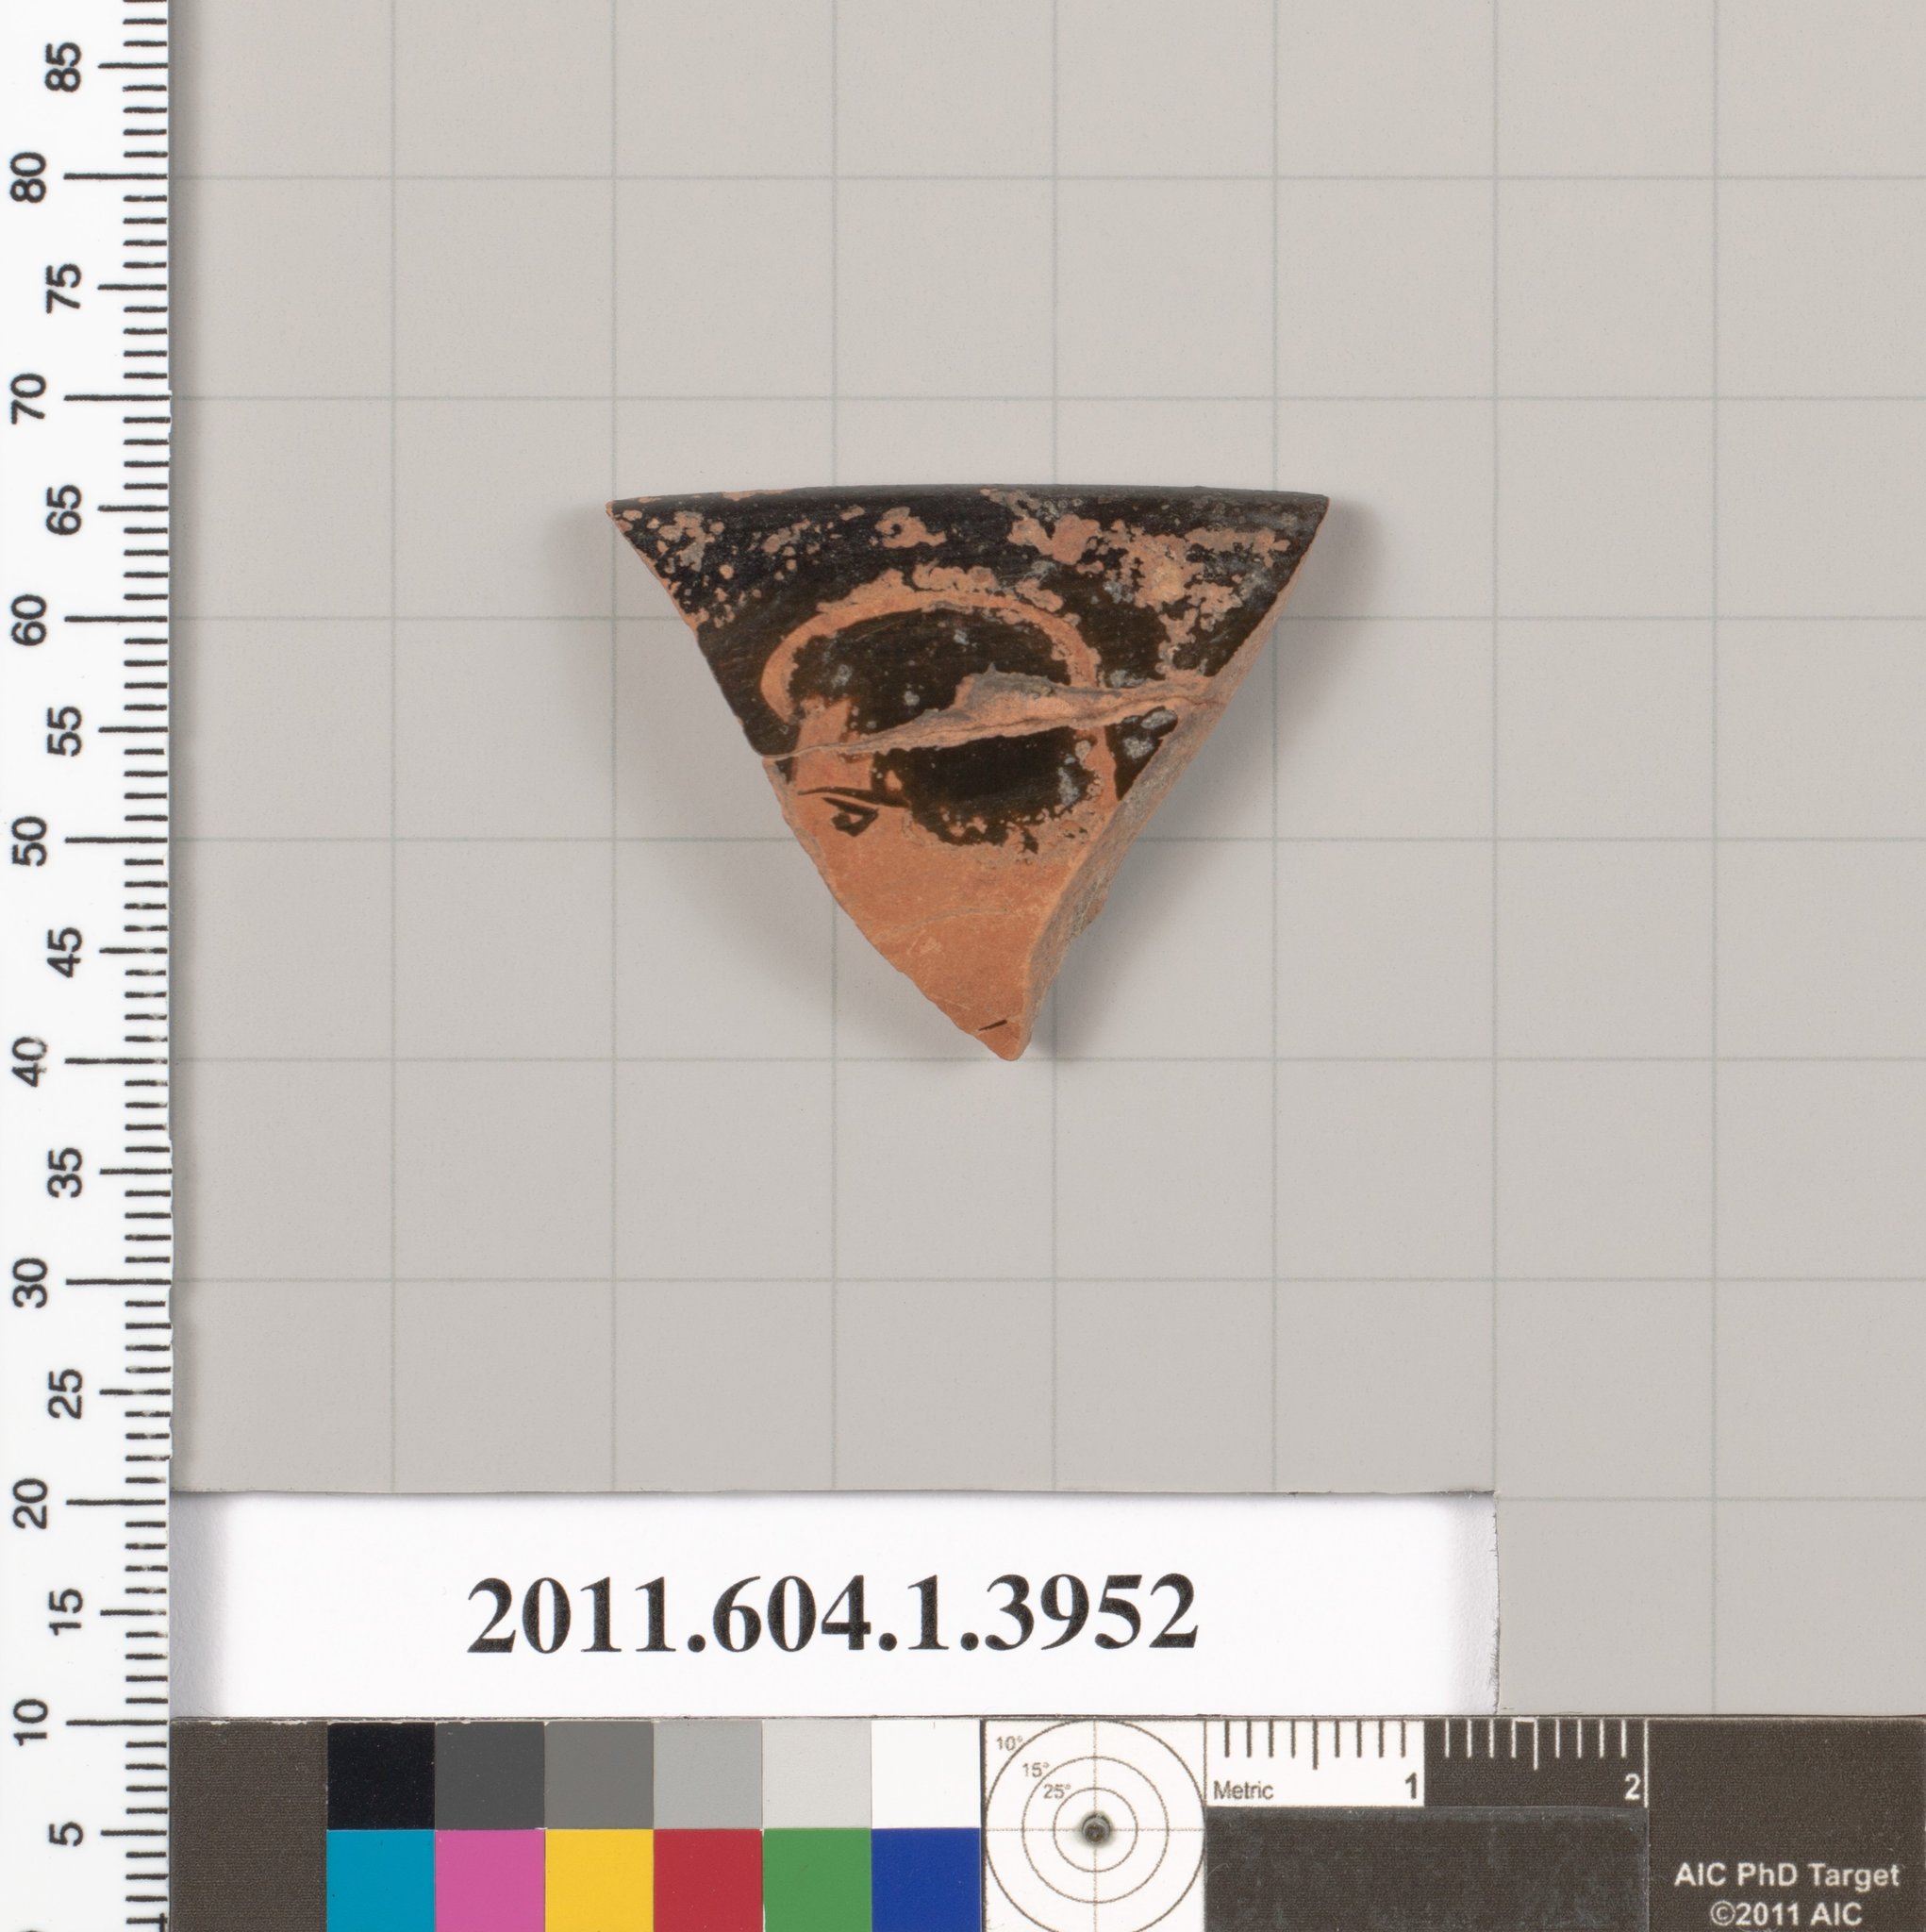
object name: kylix fragment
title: Terracotta rim fragment of a kylix (drinking cup)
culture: greek, attic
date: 467-435 BCE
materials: terracotta